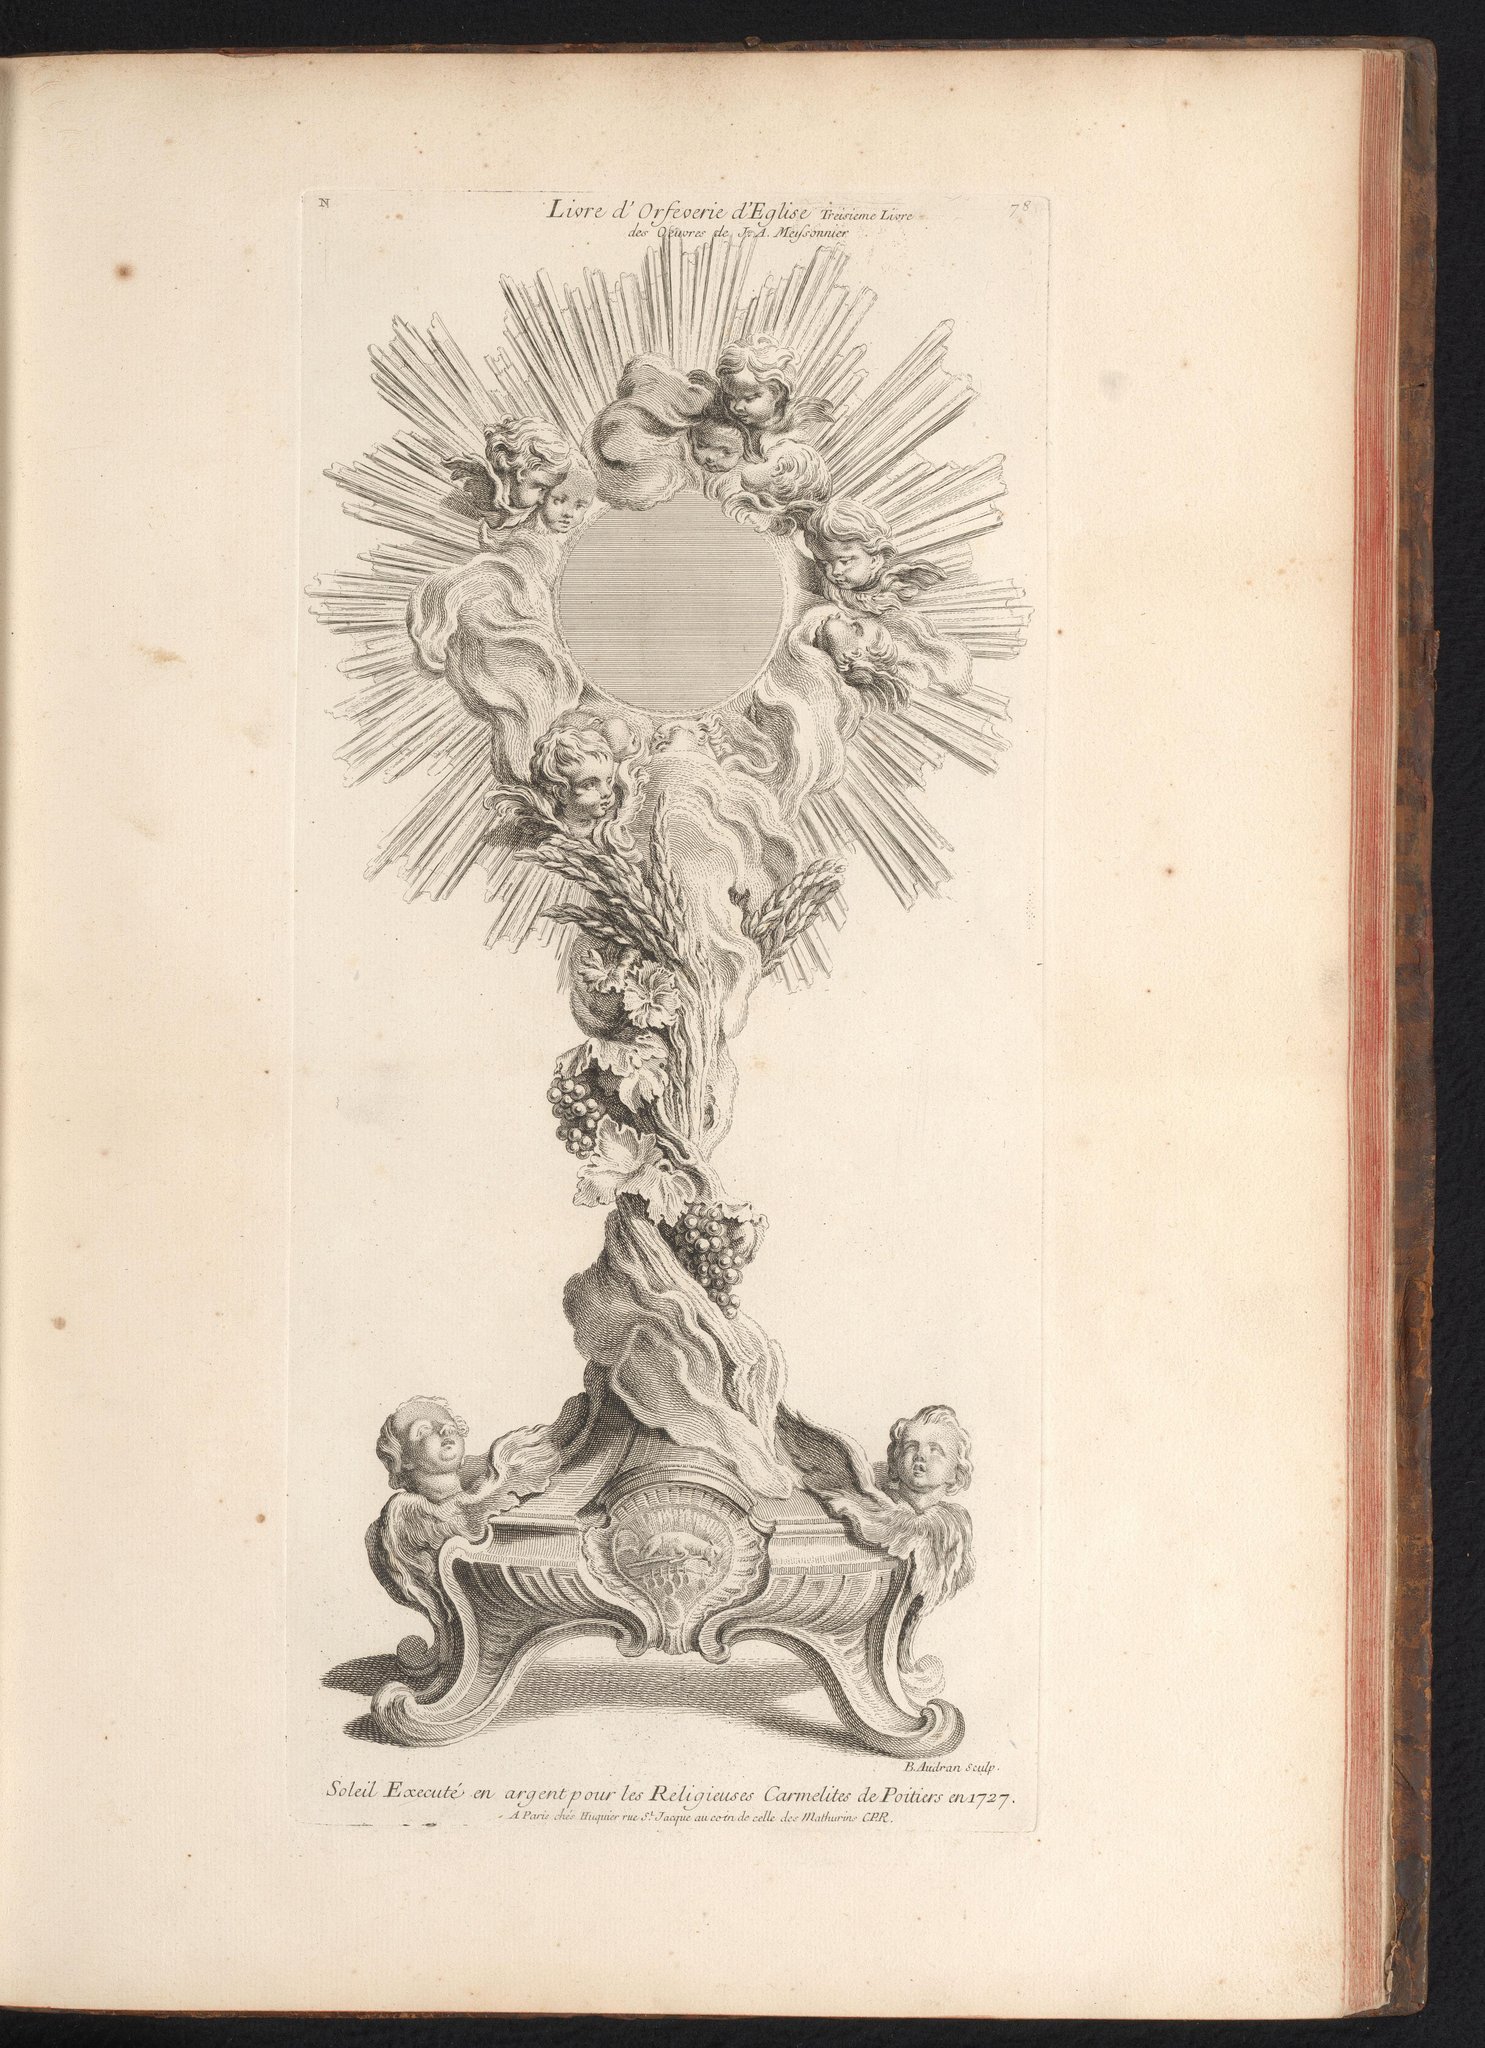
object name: album leaf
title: Soleil executé en argent pour les religieuses Carmelites de Poitier en 1727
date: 1738-1749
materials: paper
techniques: etching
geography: paris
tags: ostensorium, monstrance, work of applied art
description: Deze prent maakt deel uit van de serie "Treisieme livre des oeuvres de J.A. Meissonnier", een van de delen van de monumentale reeks "Oeuvre de Juste Aurele Meissonnier".